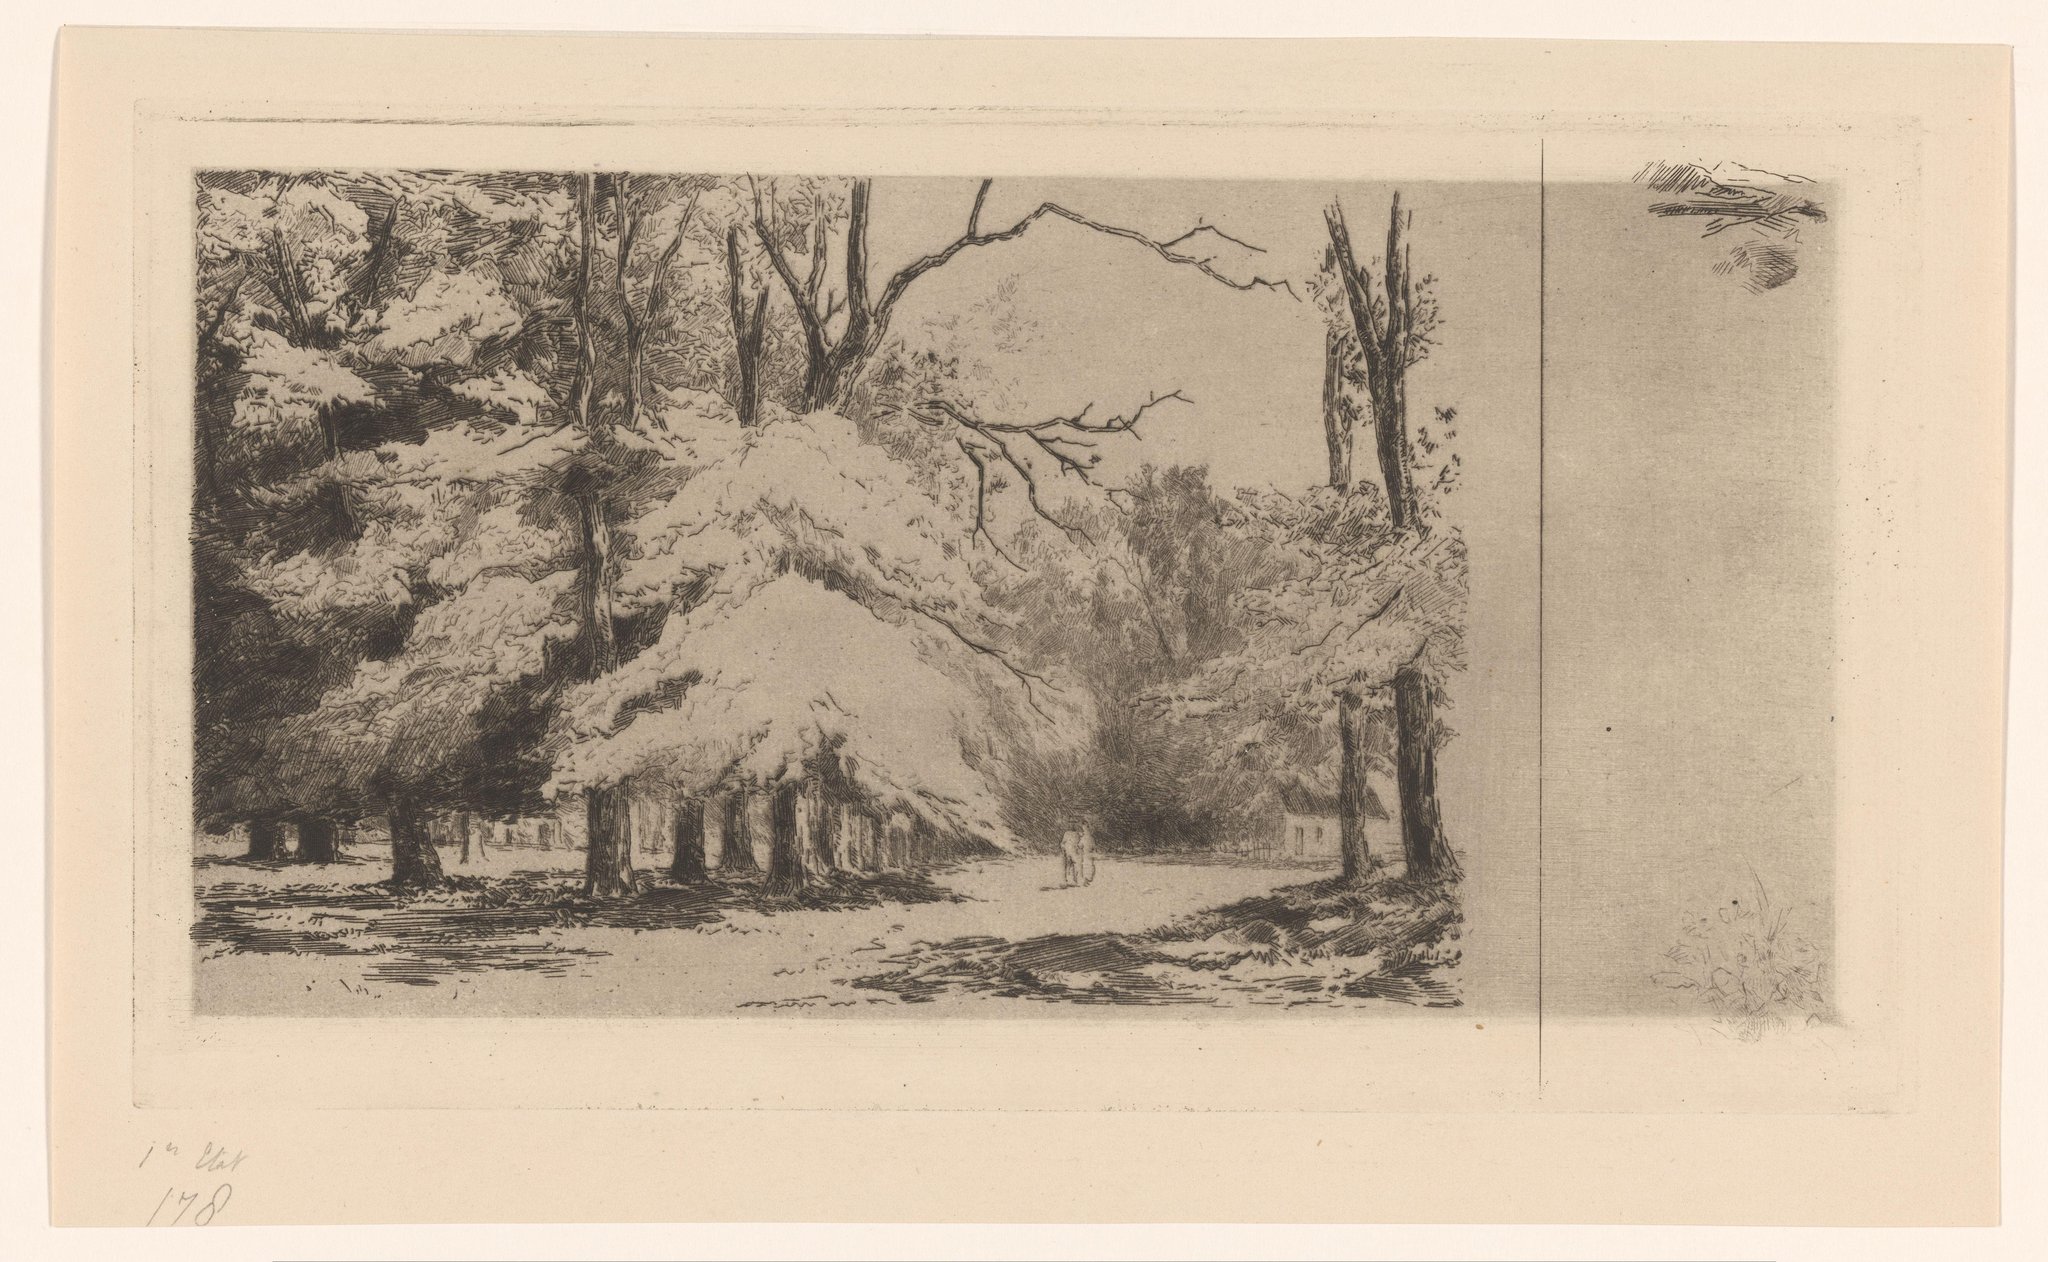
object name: print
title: Bosgezicht met twee wandelaars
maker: carel nicolaas storm van s-gravesande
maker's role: draughtsman, print maker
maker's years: 1841-1924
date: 1851-1910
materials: paper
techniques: drypoint, etching, intaglio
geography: netherlands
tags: forest, wood (+ landscape with figures, staffage)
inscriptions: collector's mark: Lugt 2228